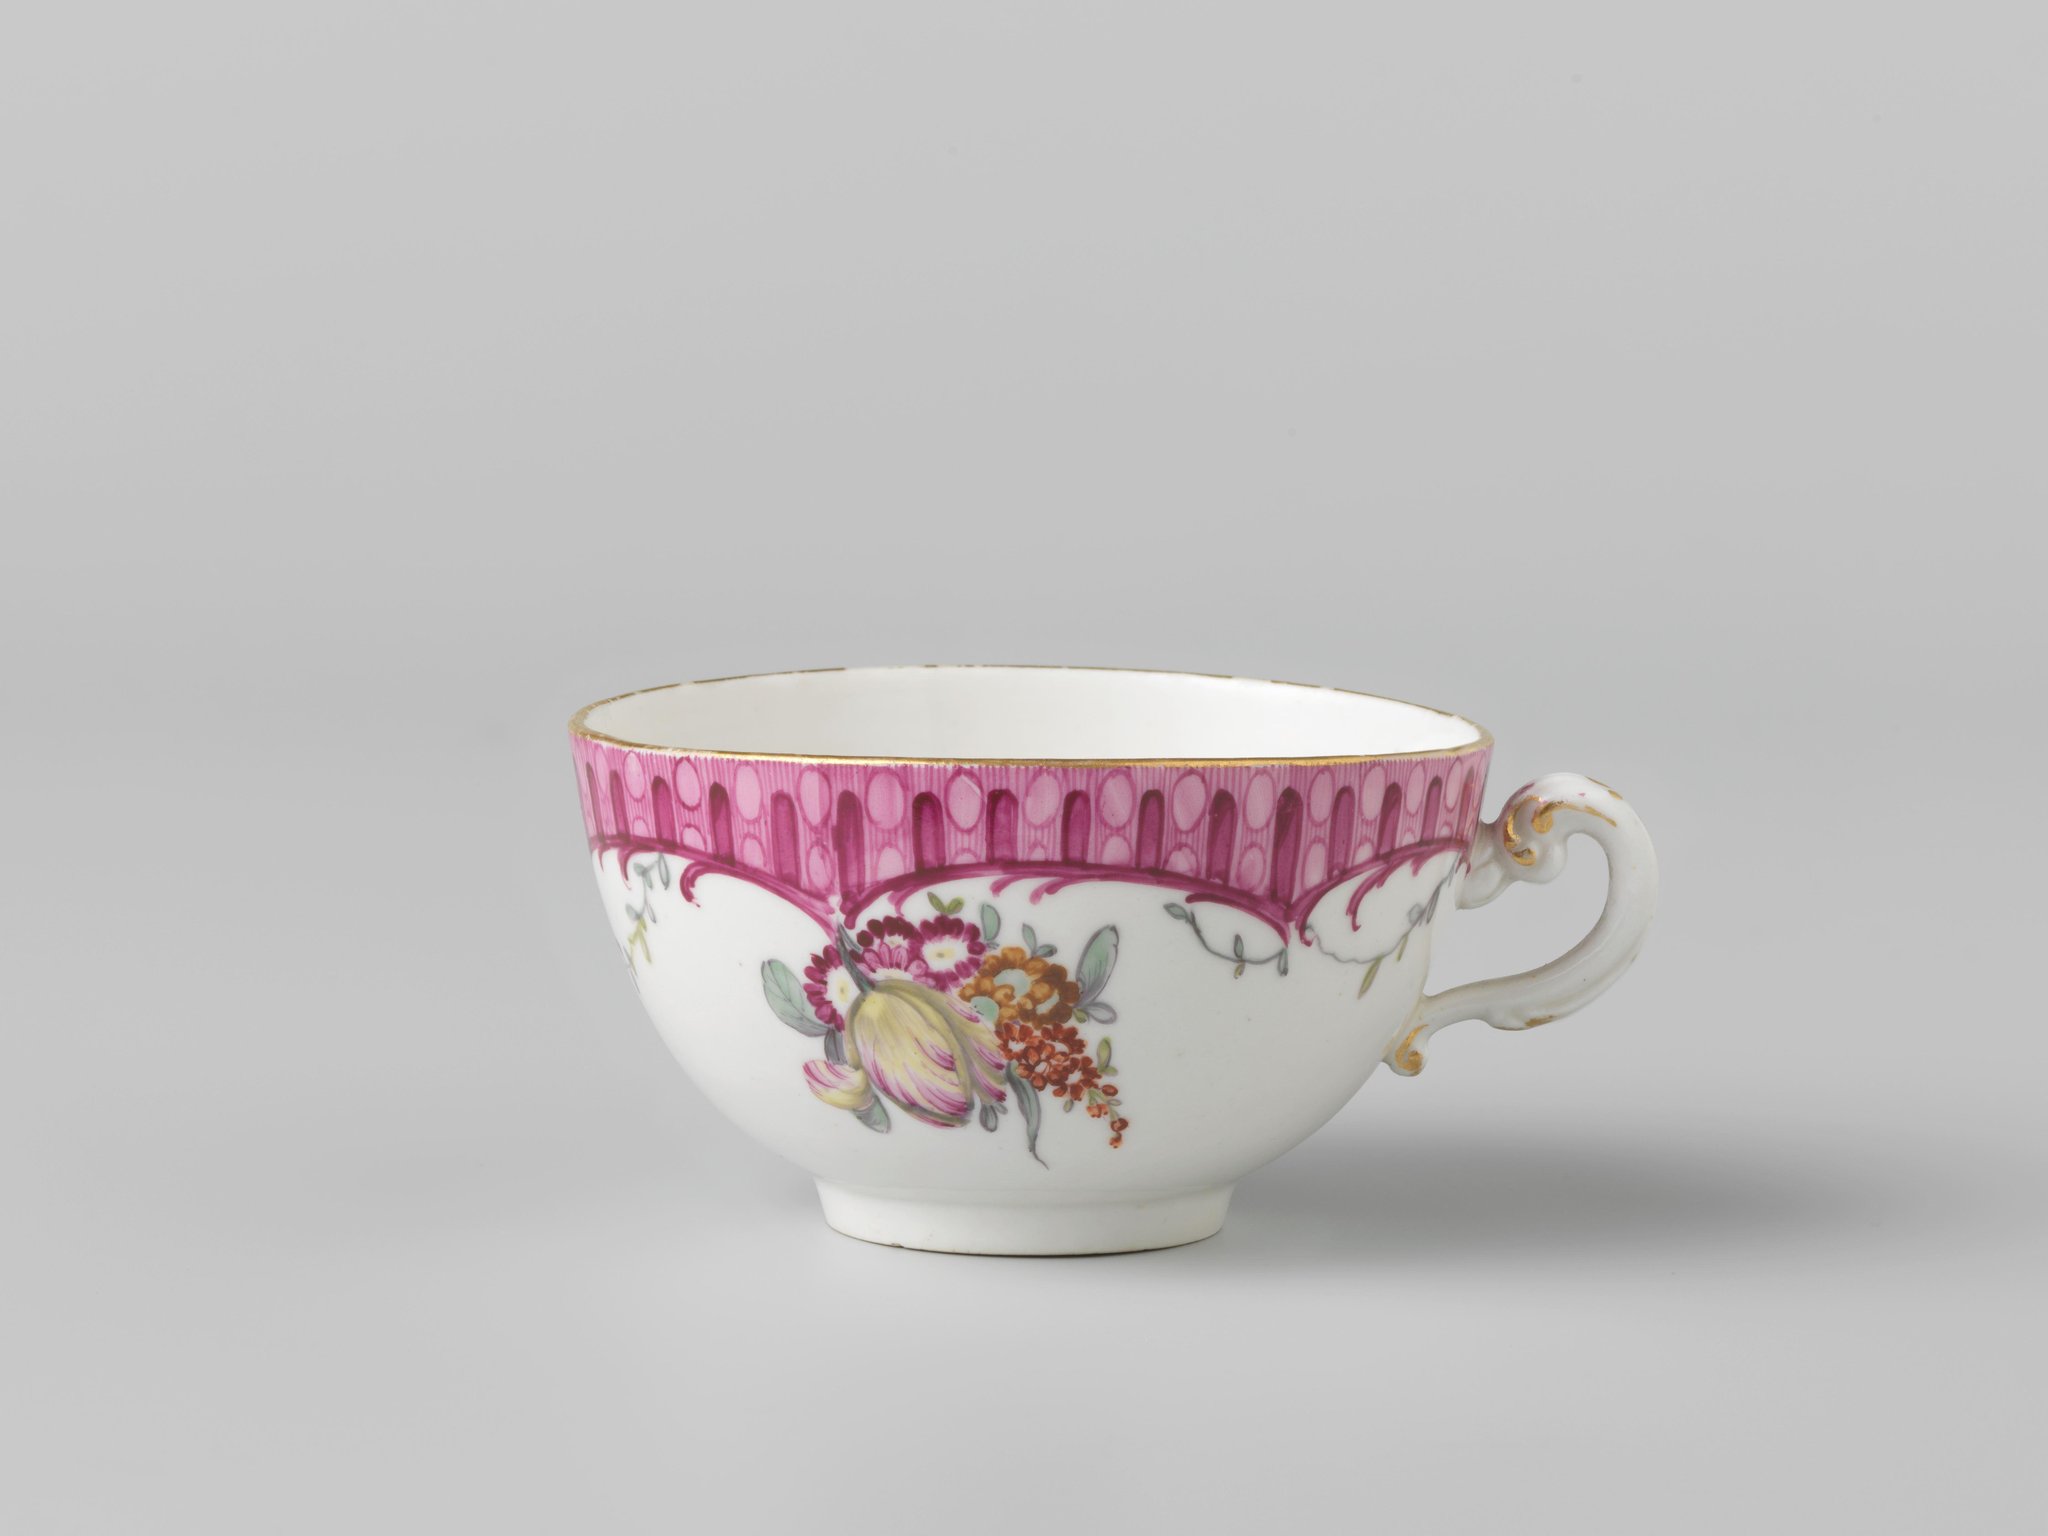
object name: cup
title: Kop, beschilderd met ornamentband, waaraan een bladguirlande en een bloemboeket hangen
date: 1774-1778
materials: porcelain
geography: loosdrecht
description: Coffee cup and saucer, c. 1774 - 1778.